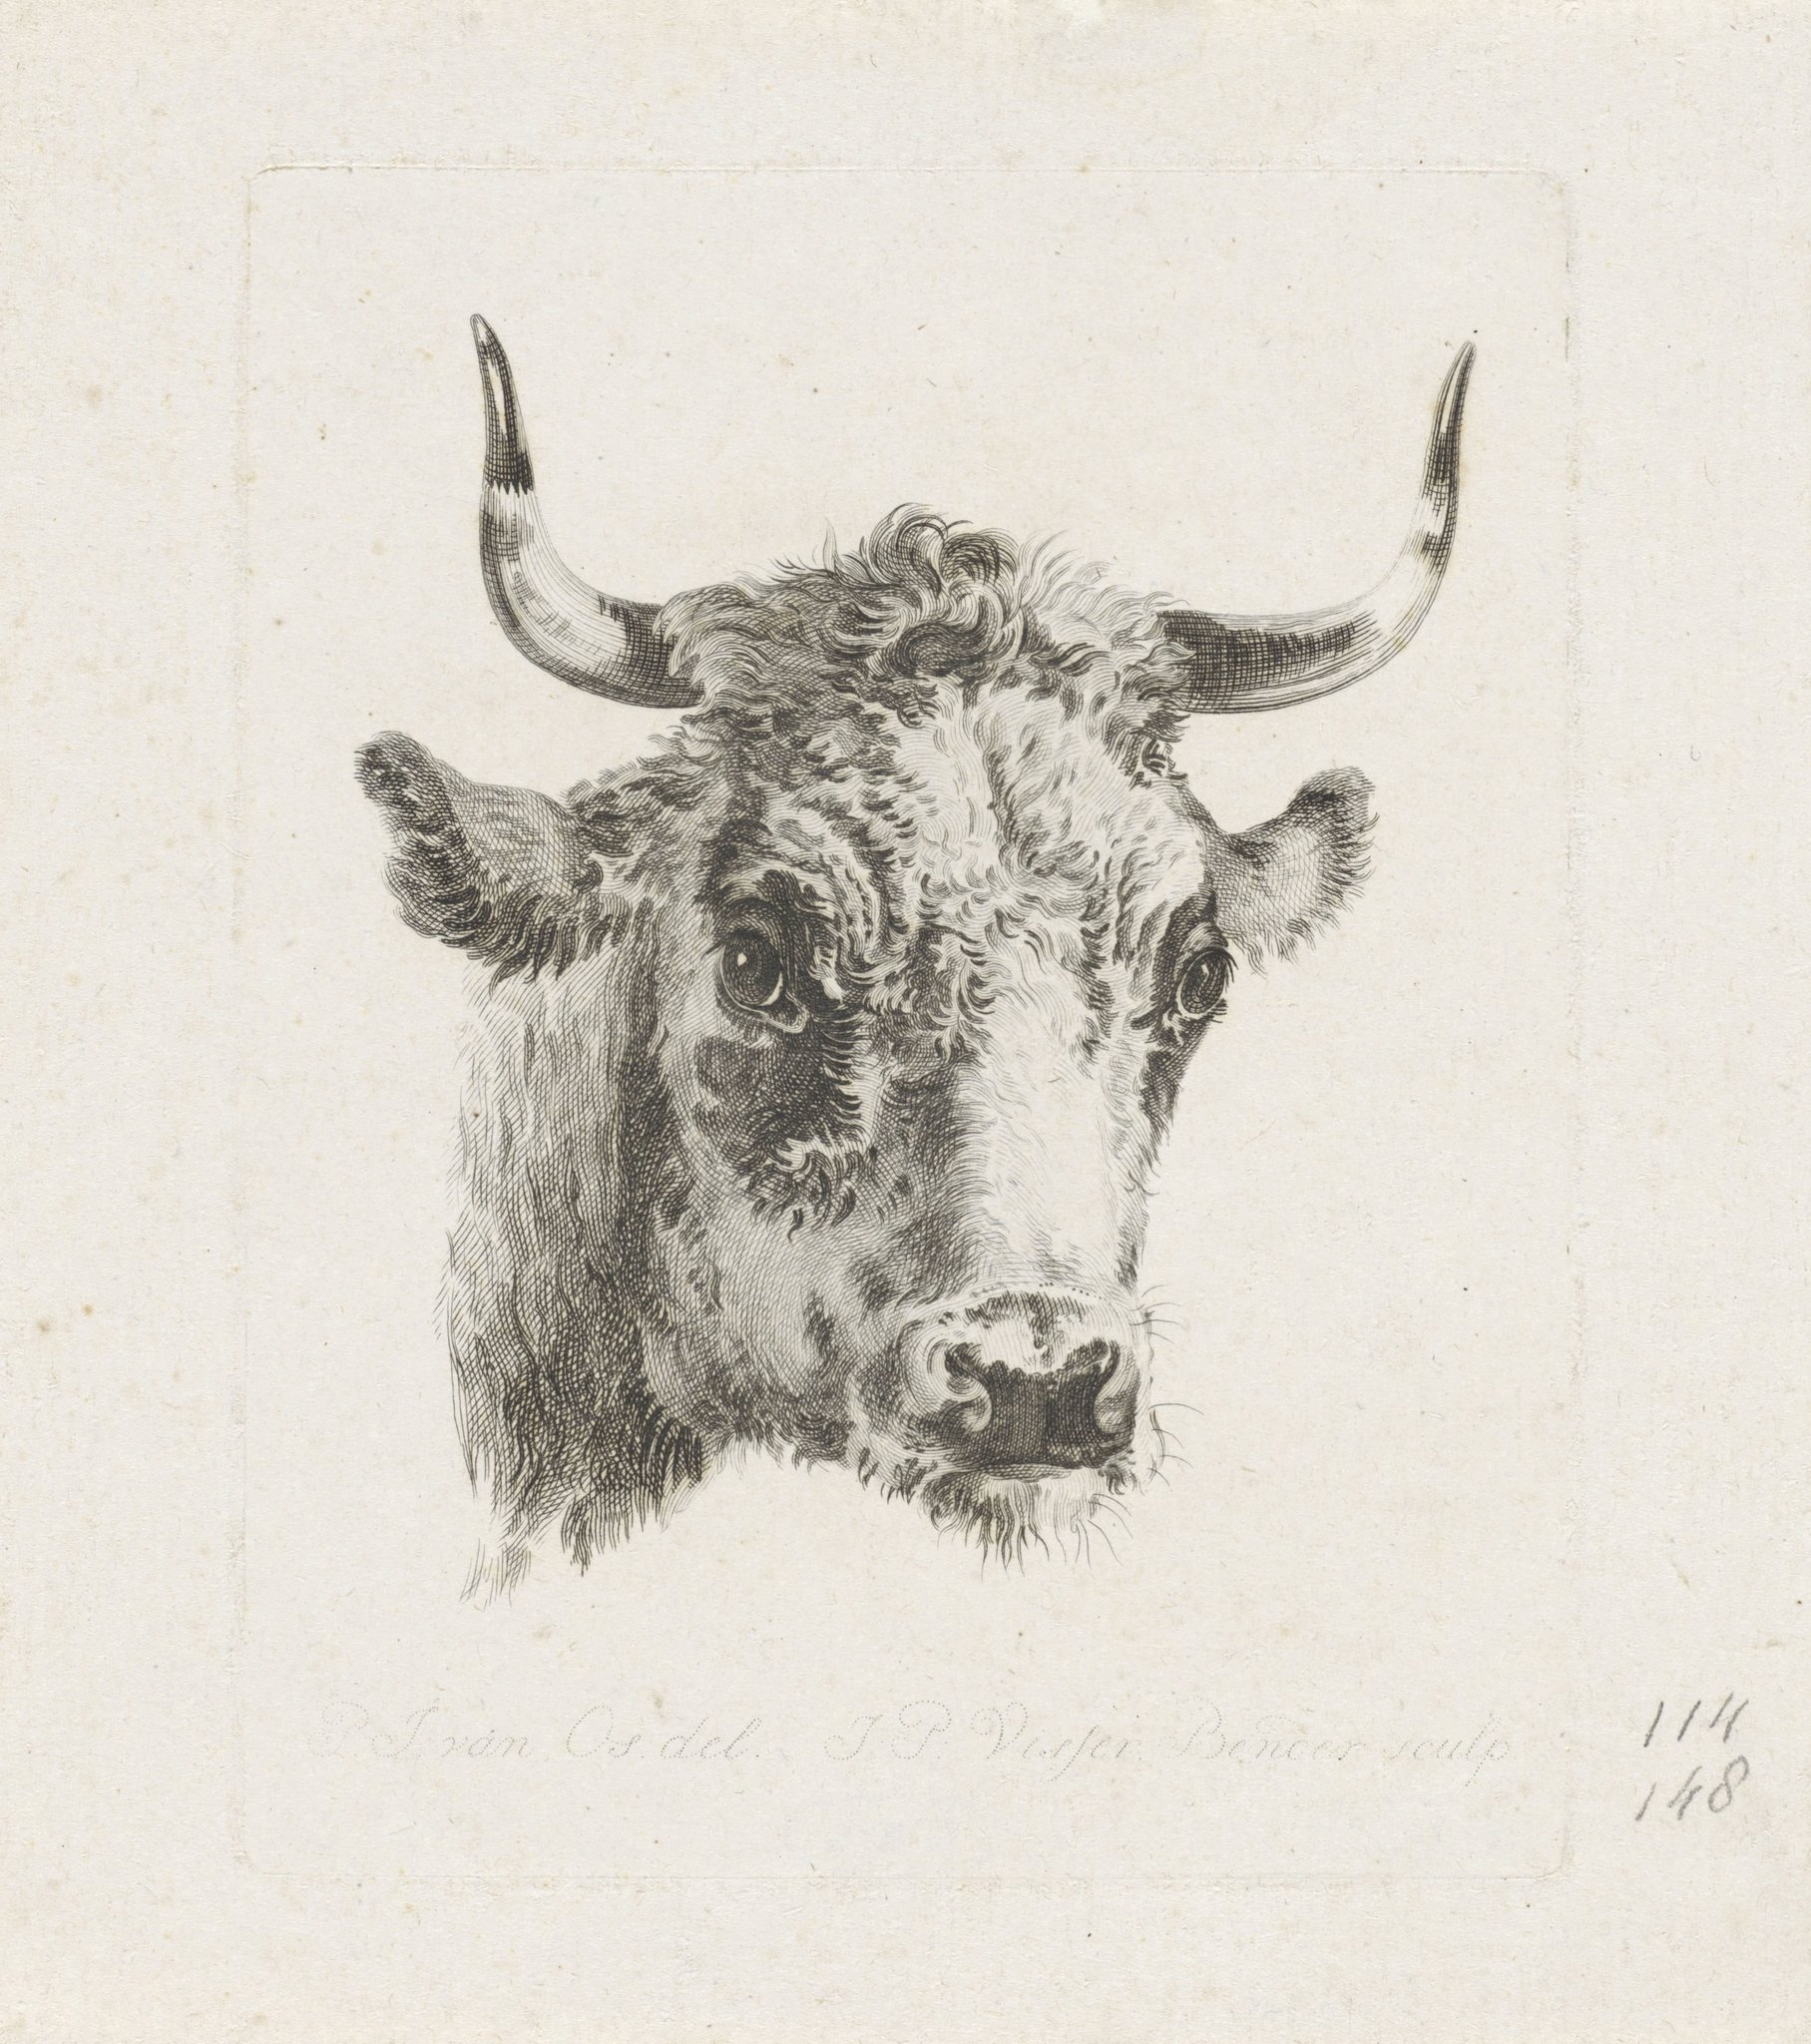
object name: print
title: Regnault de St. Jean dangely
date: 1818-1842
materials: paper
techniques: lithograph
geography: paris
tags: paris, politician, historical persons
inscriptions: collector's mark: Lugt 2228a